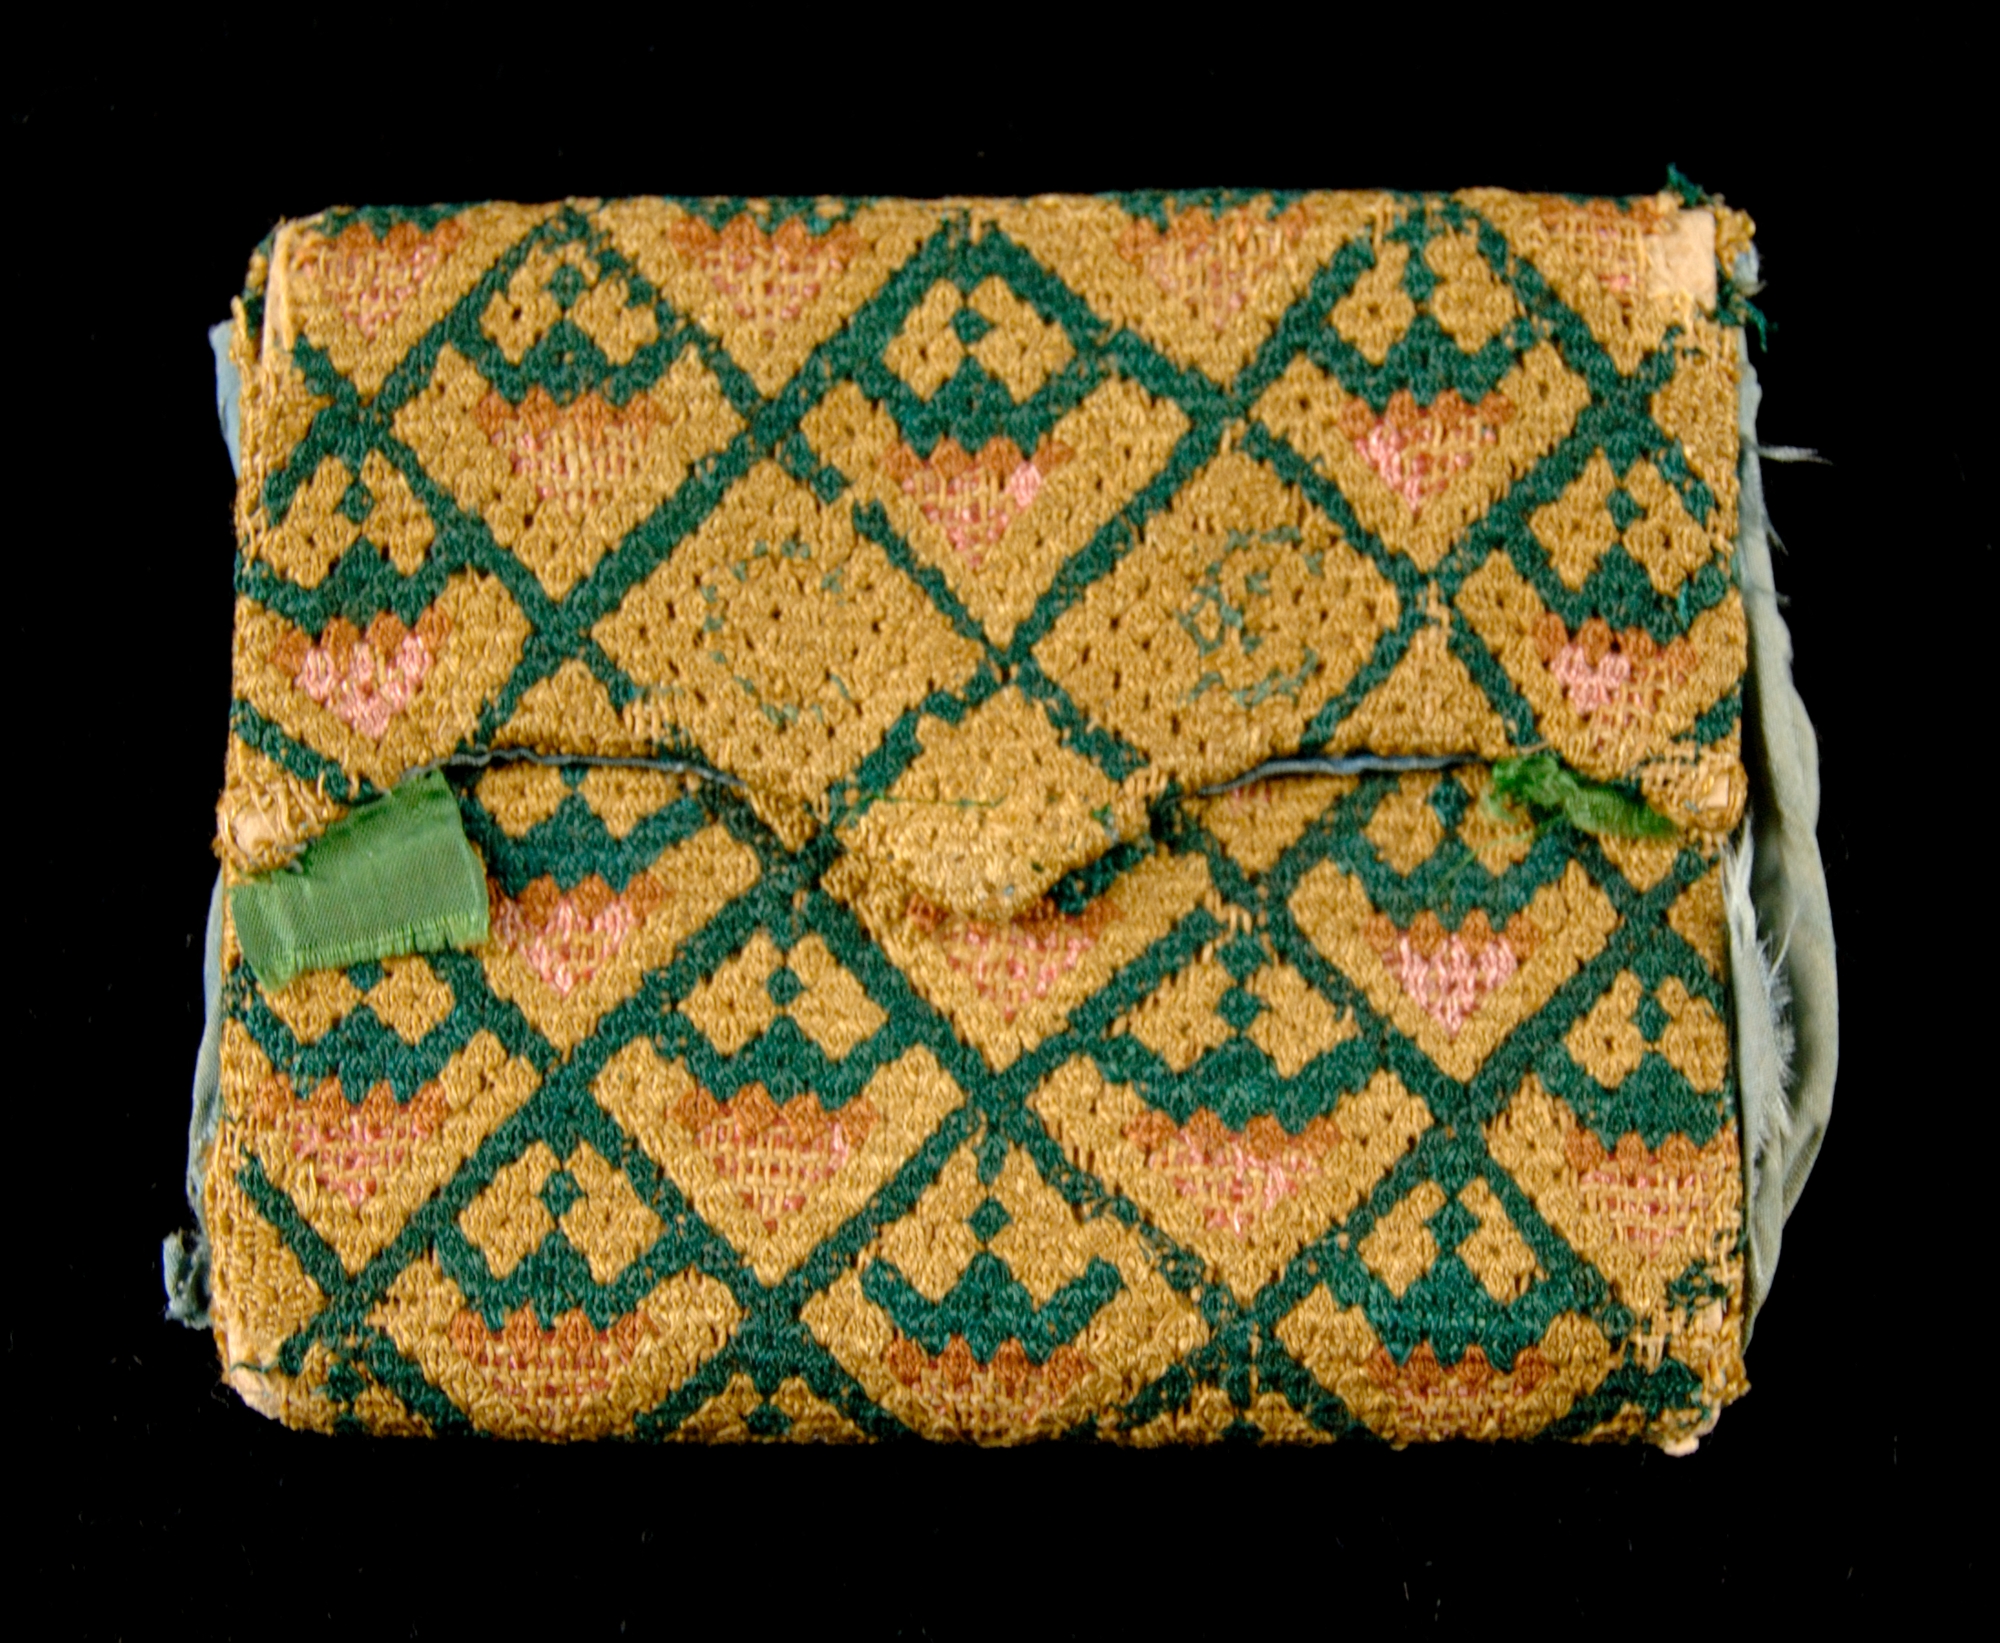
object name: bag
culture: american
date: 1740-1760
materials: linen, silk